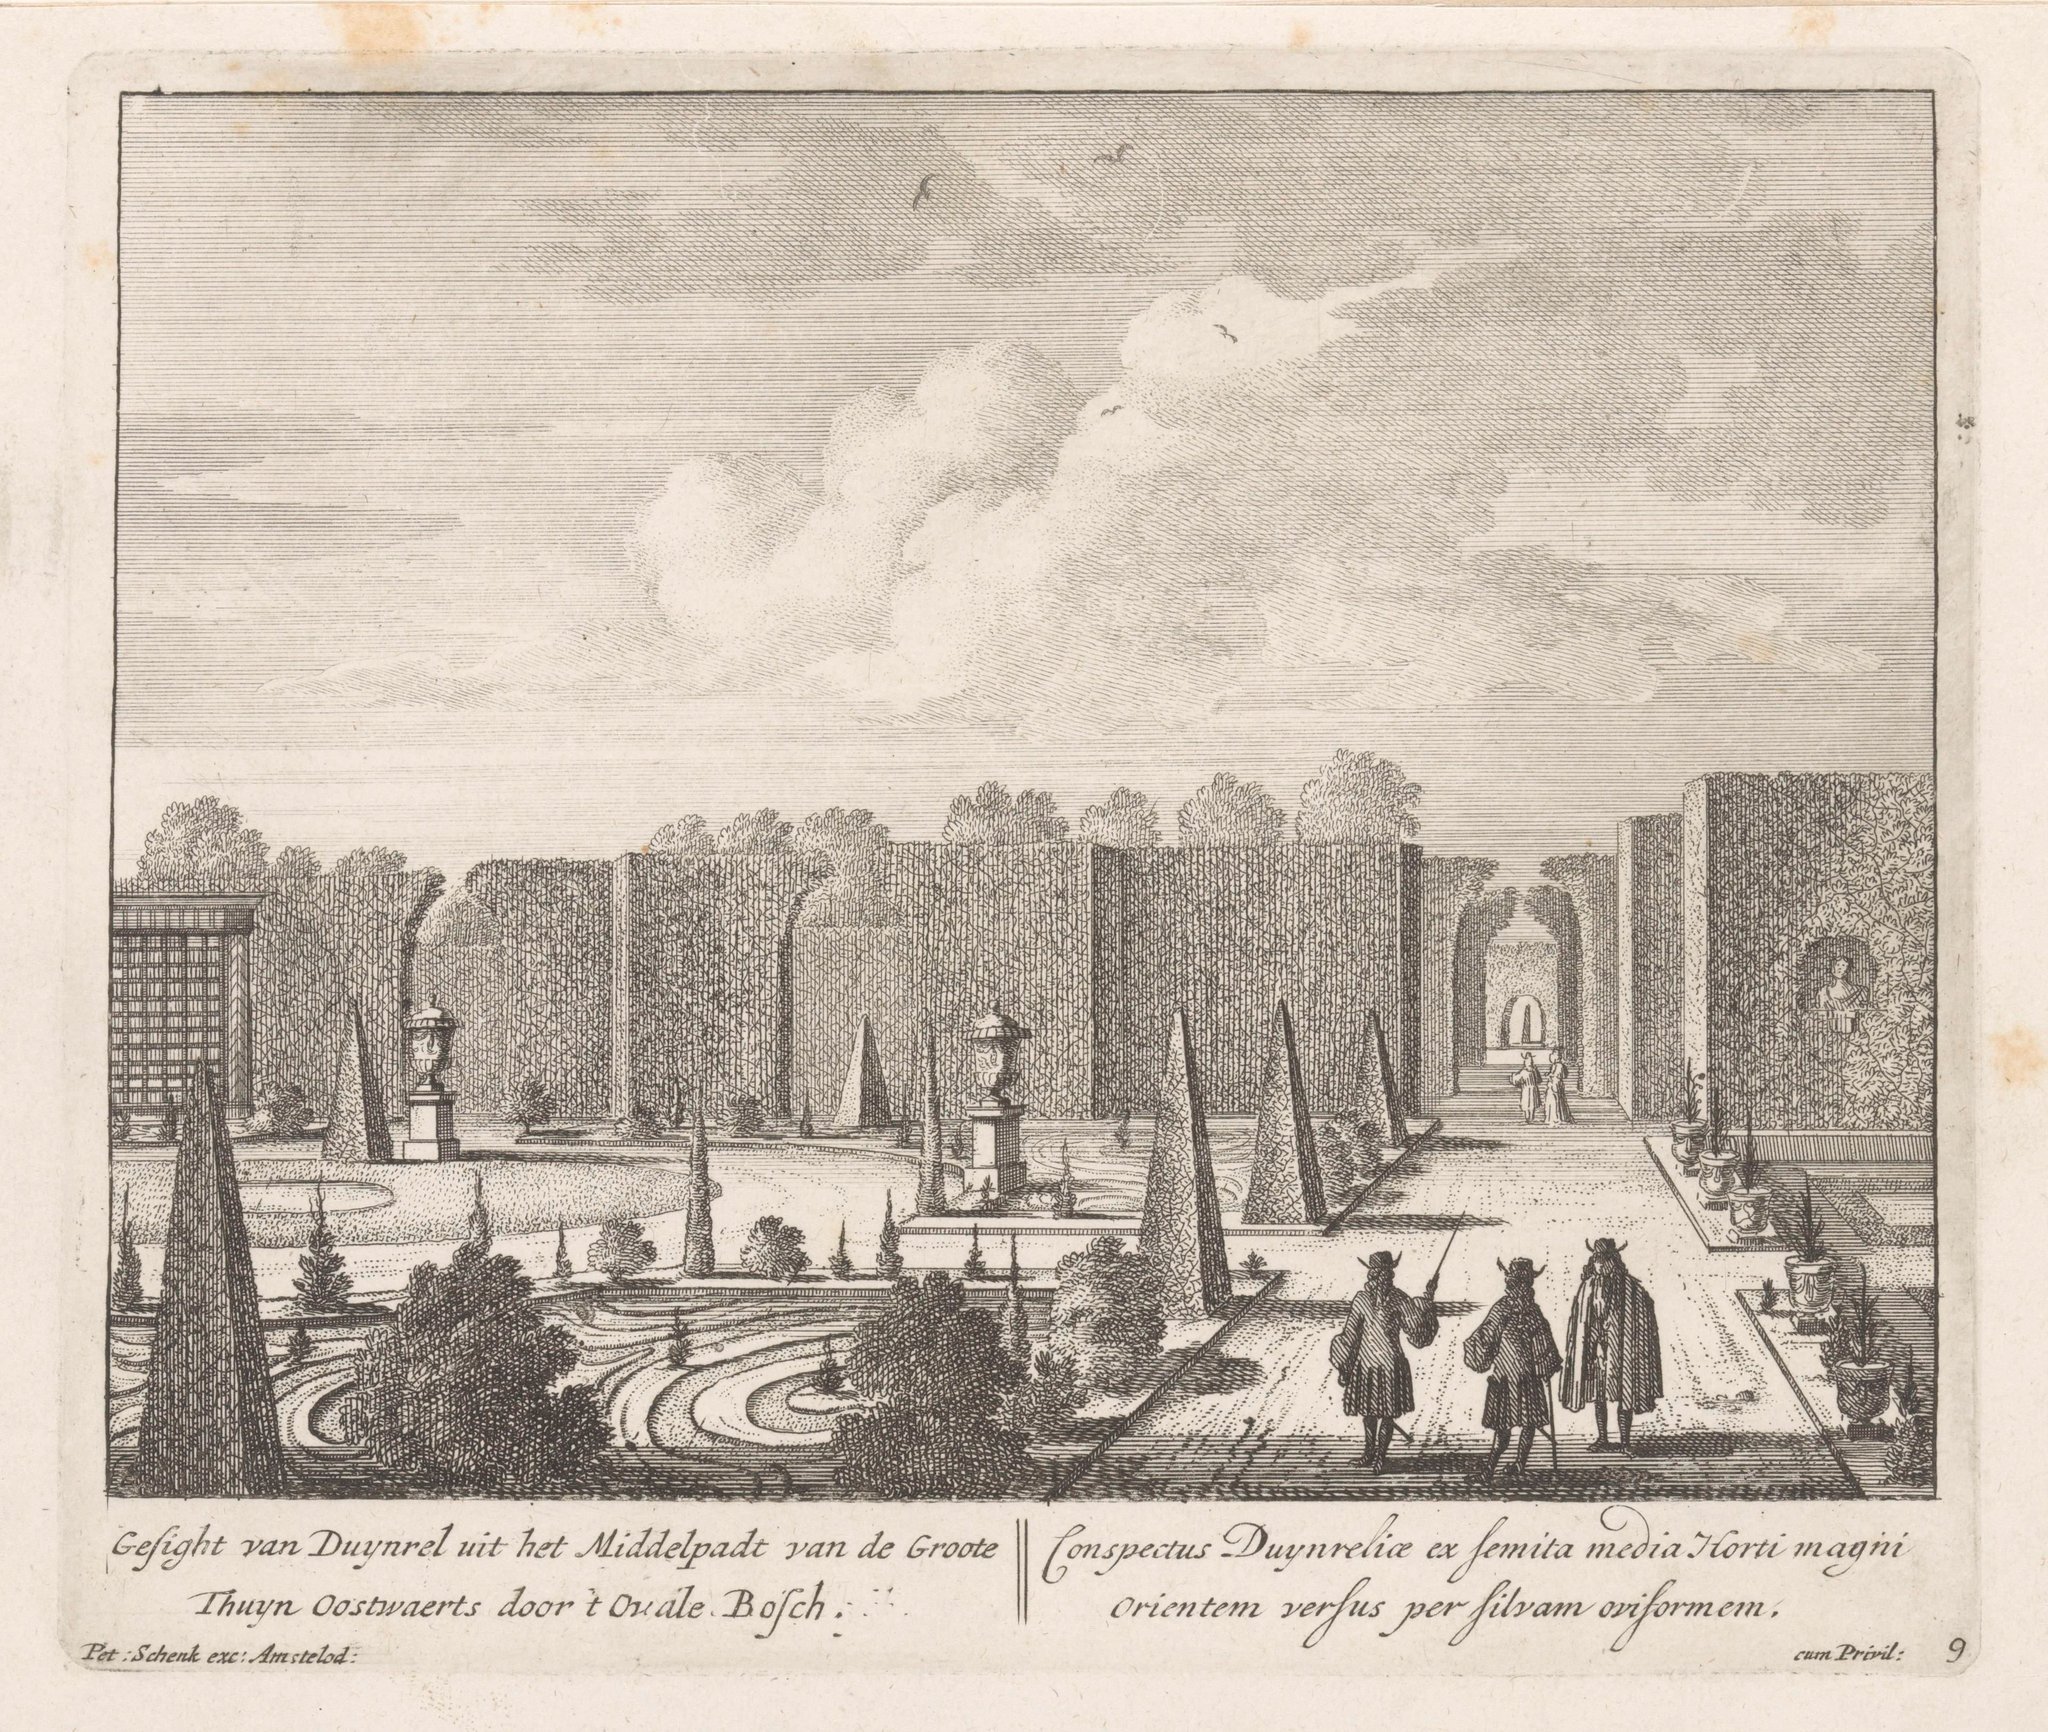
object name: print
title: Gezichten op de buitenplaats Duinrell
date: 1675-1711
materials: paper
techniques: engraving, etching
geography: amsterdam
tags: french or architectonic garden; formal garden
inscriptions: collector's mark: Lugt 2228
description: Gezicht op het ovale bos in de tuin van buitenplaats Duinrell, gezien richting het oosten. Rechts op het middenpad van de tuin enkele figuren. Rechtsonder genummerd: 9. Prent uit een serie van zestien prenten van Duinrell.